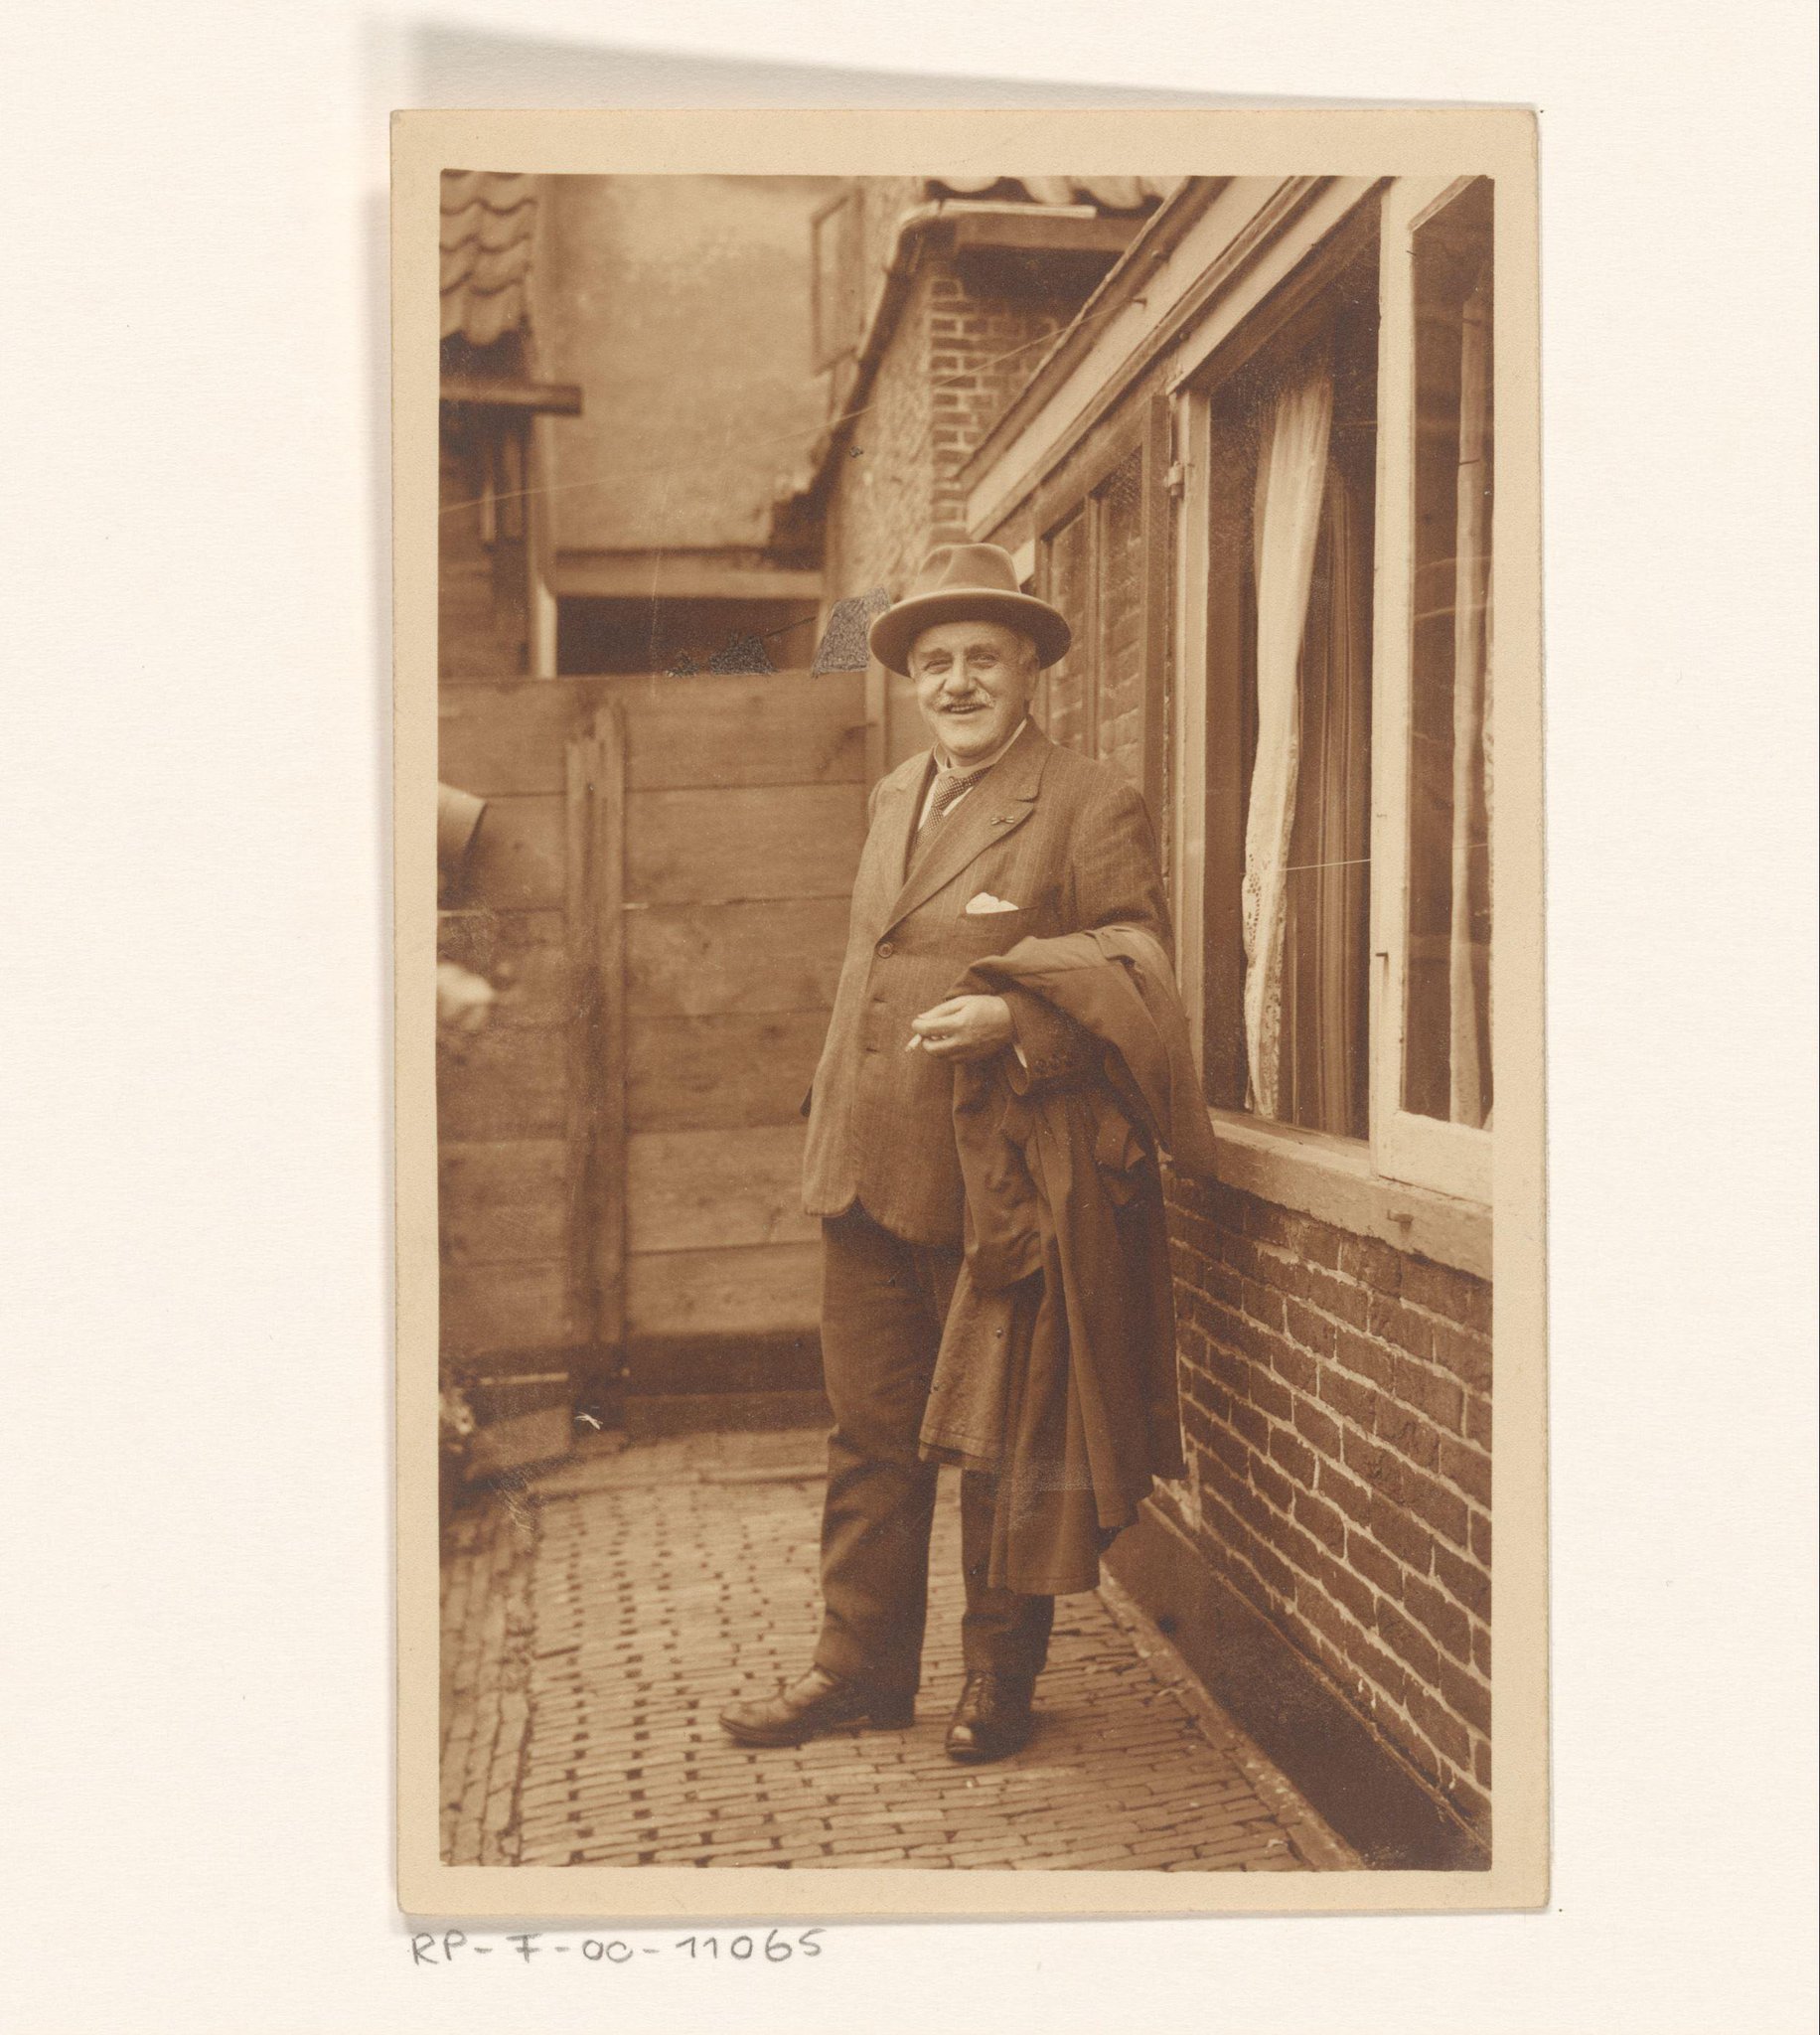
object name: photograph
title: Portret van een onbekende man met sigaret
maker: Anonymous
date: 1900-1970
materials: photographic support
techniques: collodion silver print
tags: historical persons not known by name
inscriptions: :, collector's mark: Lugt 2228a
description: De man staat op een binnenplaats en draagt een pak met hoed. Over zijn arm hangt een jas. Vermoedelijk een portret van een schrijver.